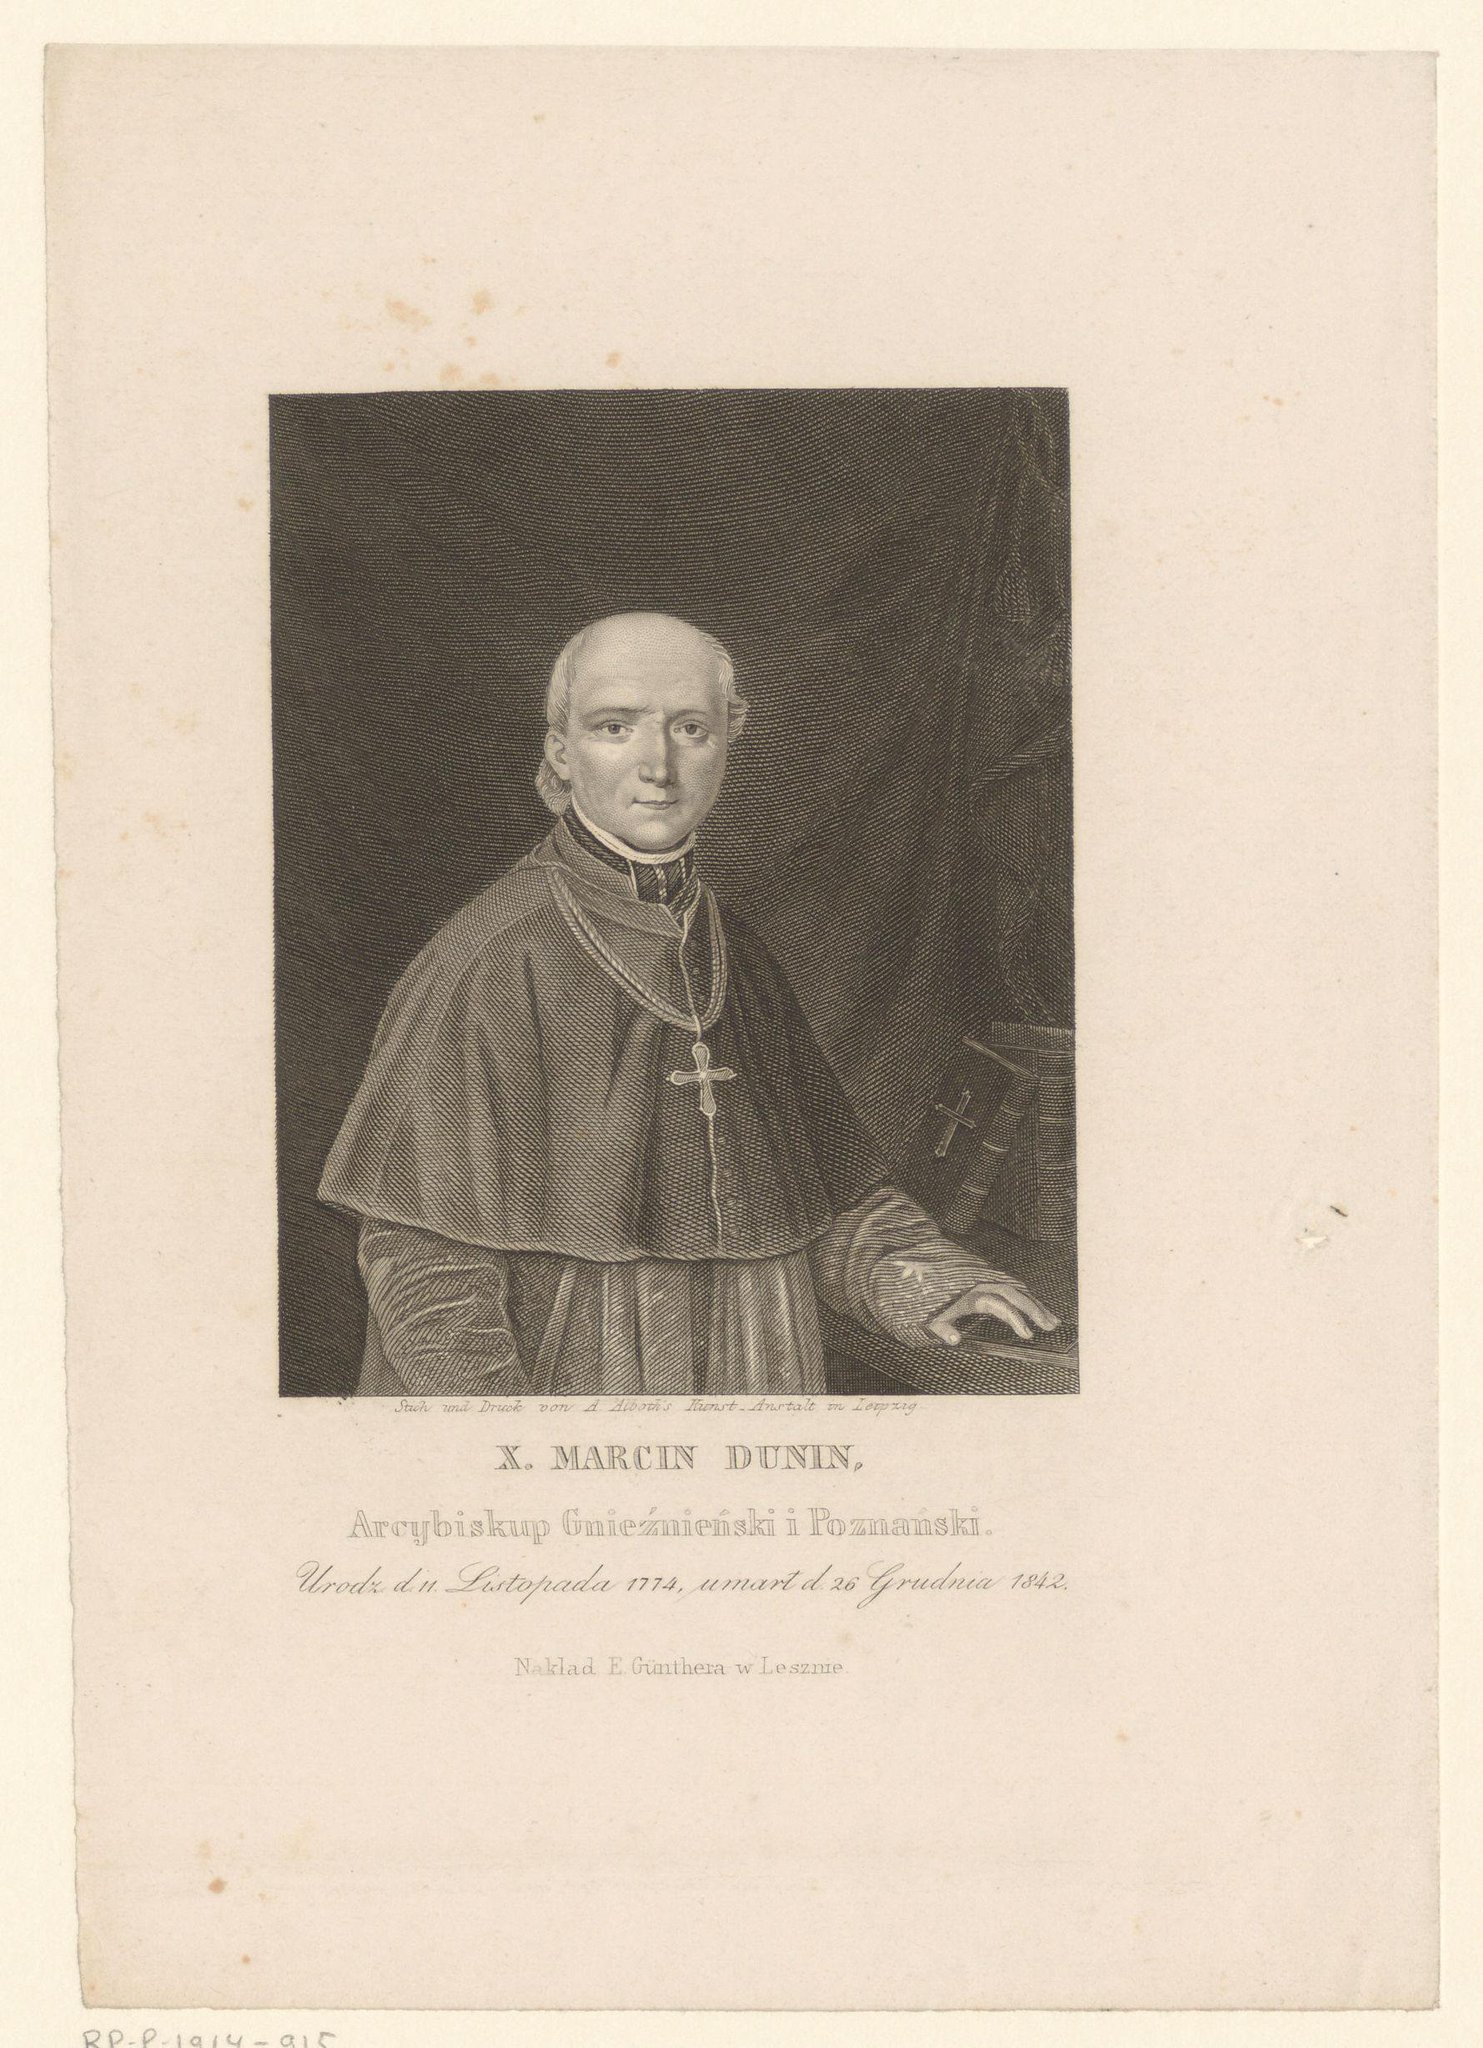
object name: print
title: X. Marcin Dunin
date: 1834-1914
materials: paper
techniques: etching, engraving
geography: leszno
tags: historical persons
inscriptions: collector's mark: Lugt 2228